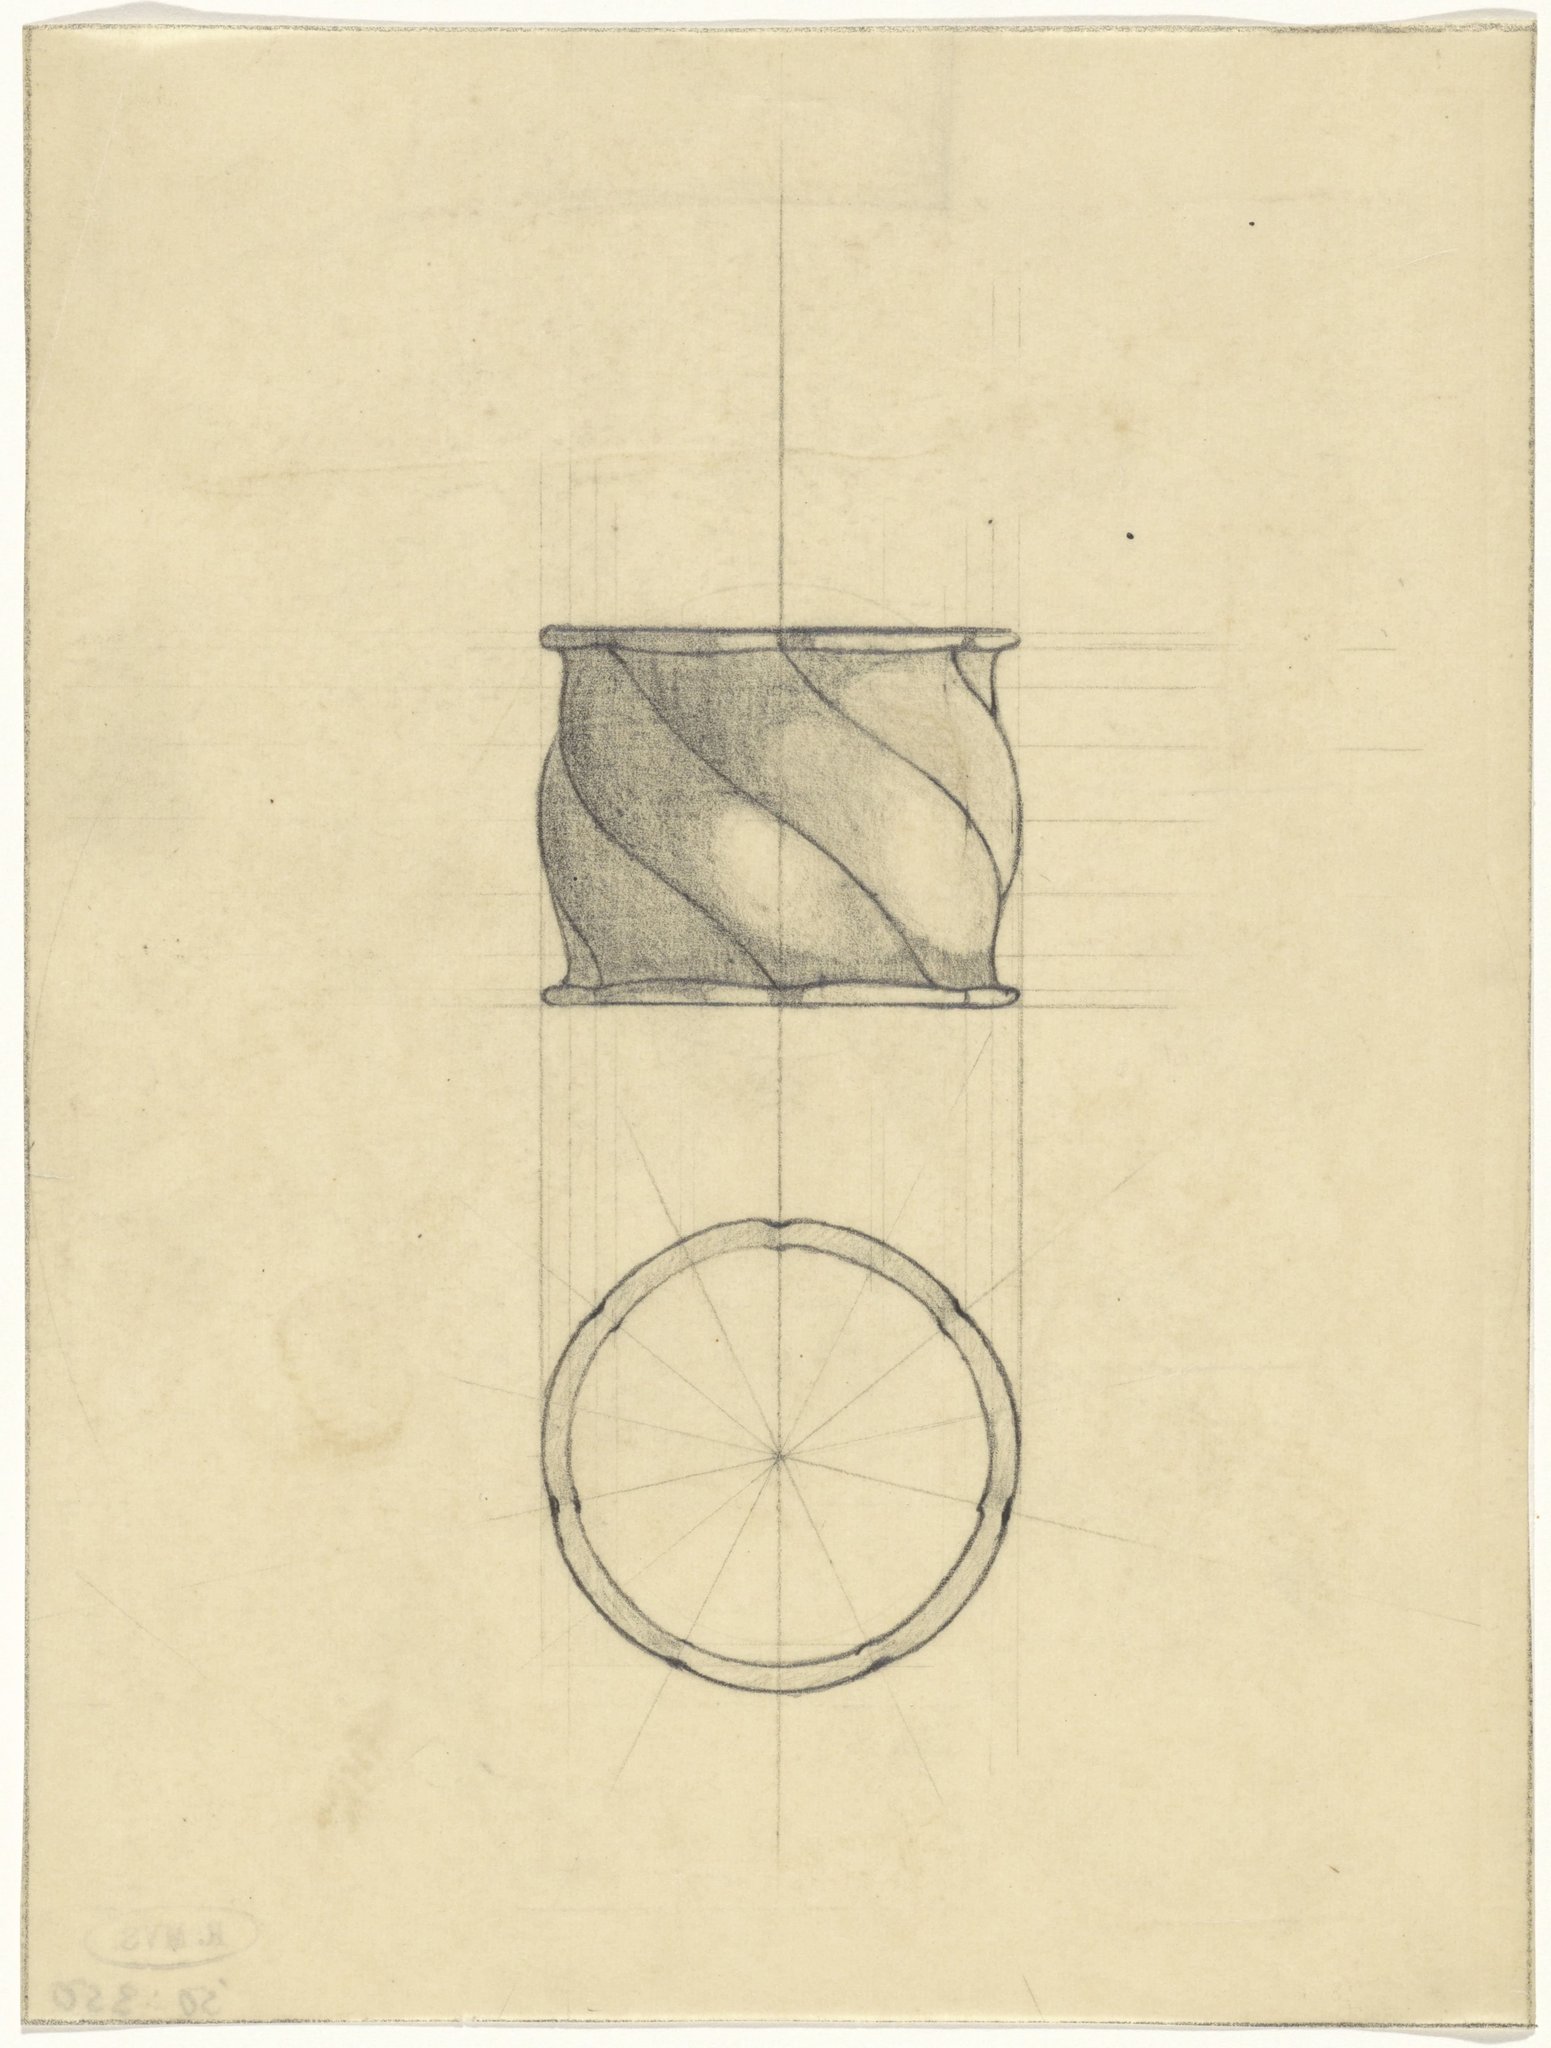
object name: design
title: Ontwerp voor een servetring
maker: mathieu lauweriks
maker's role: designer, draughtsman, print maker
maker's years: 1864-1932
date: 1874-1932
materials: pencil, paper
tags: napkin-ring